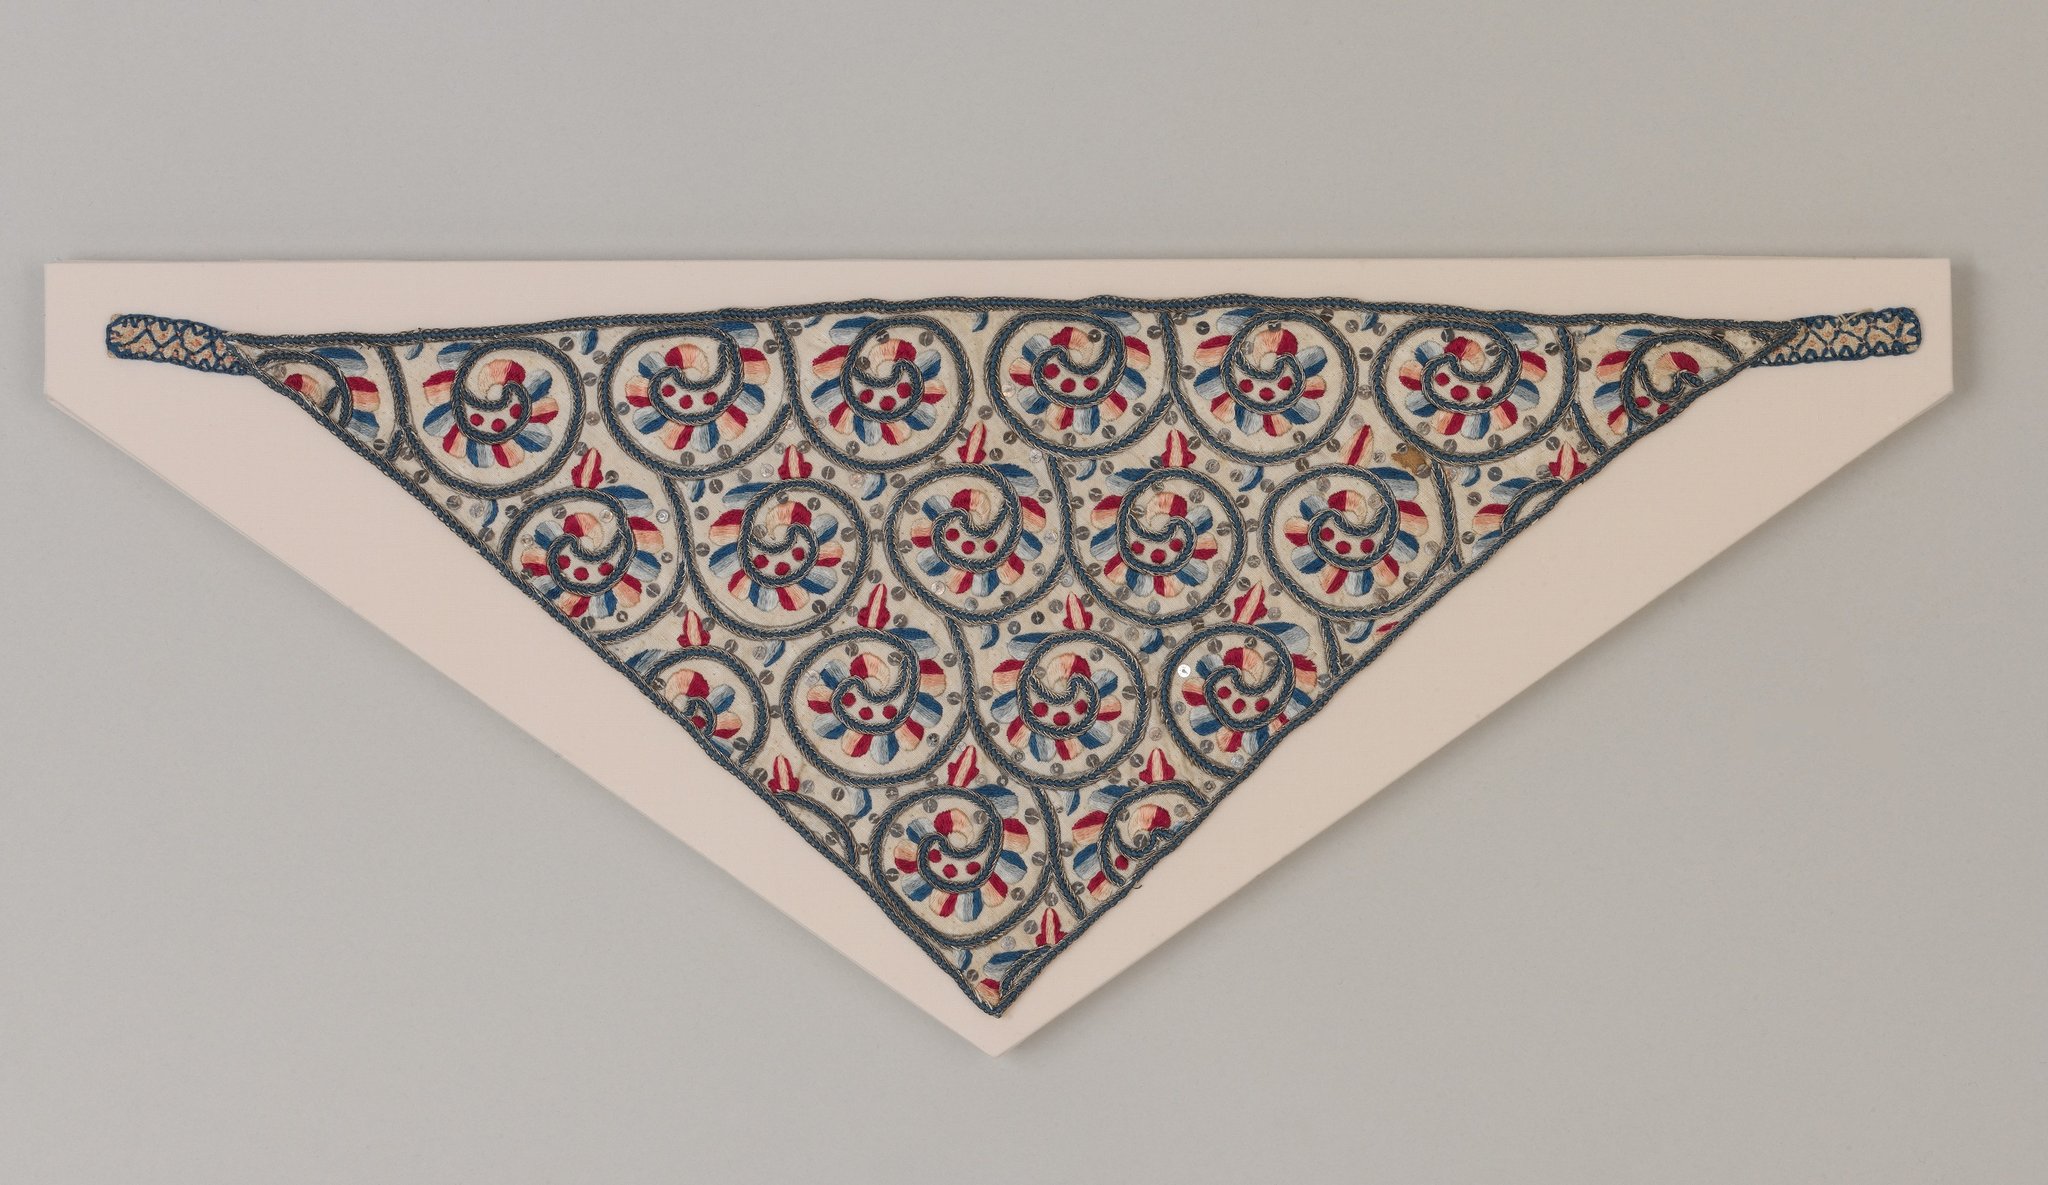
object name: forehead cloth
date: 1600-1630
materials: linen, metal thread, textile, silk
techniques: embroidery, stitching